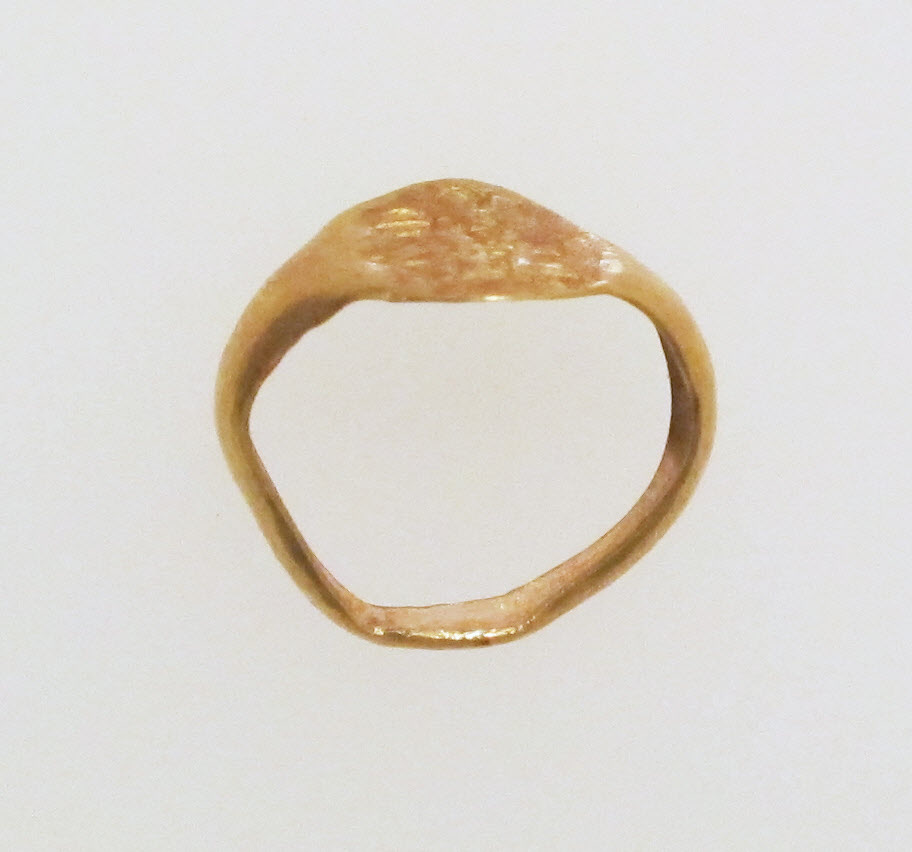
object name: ring, motto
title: Gold ring with inscribed bezel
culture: roman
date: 100 BCE-300 CE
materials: gold